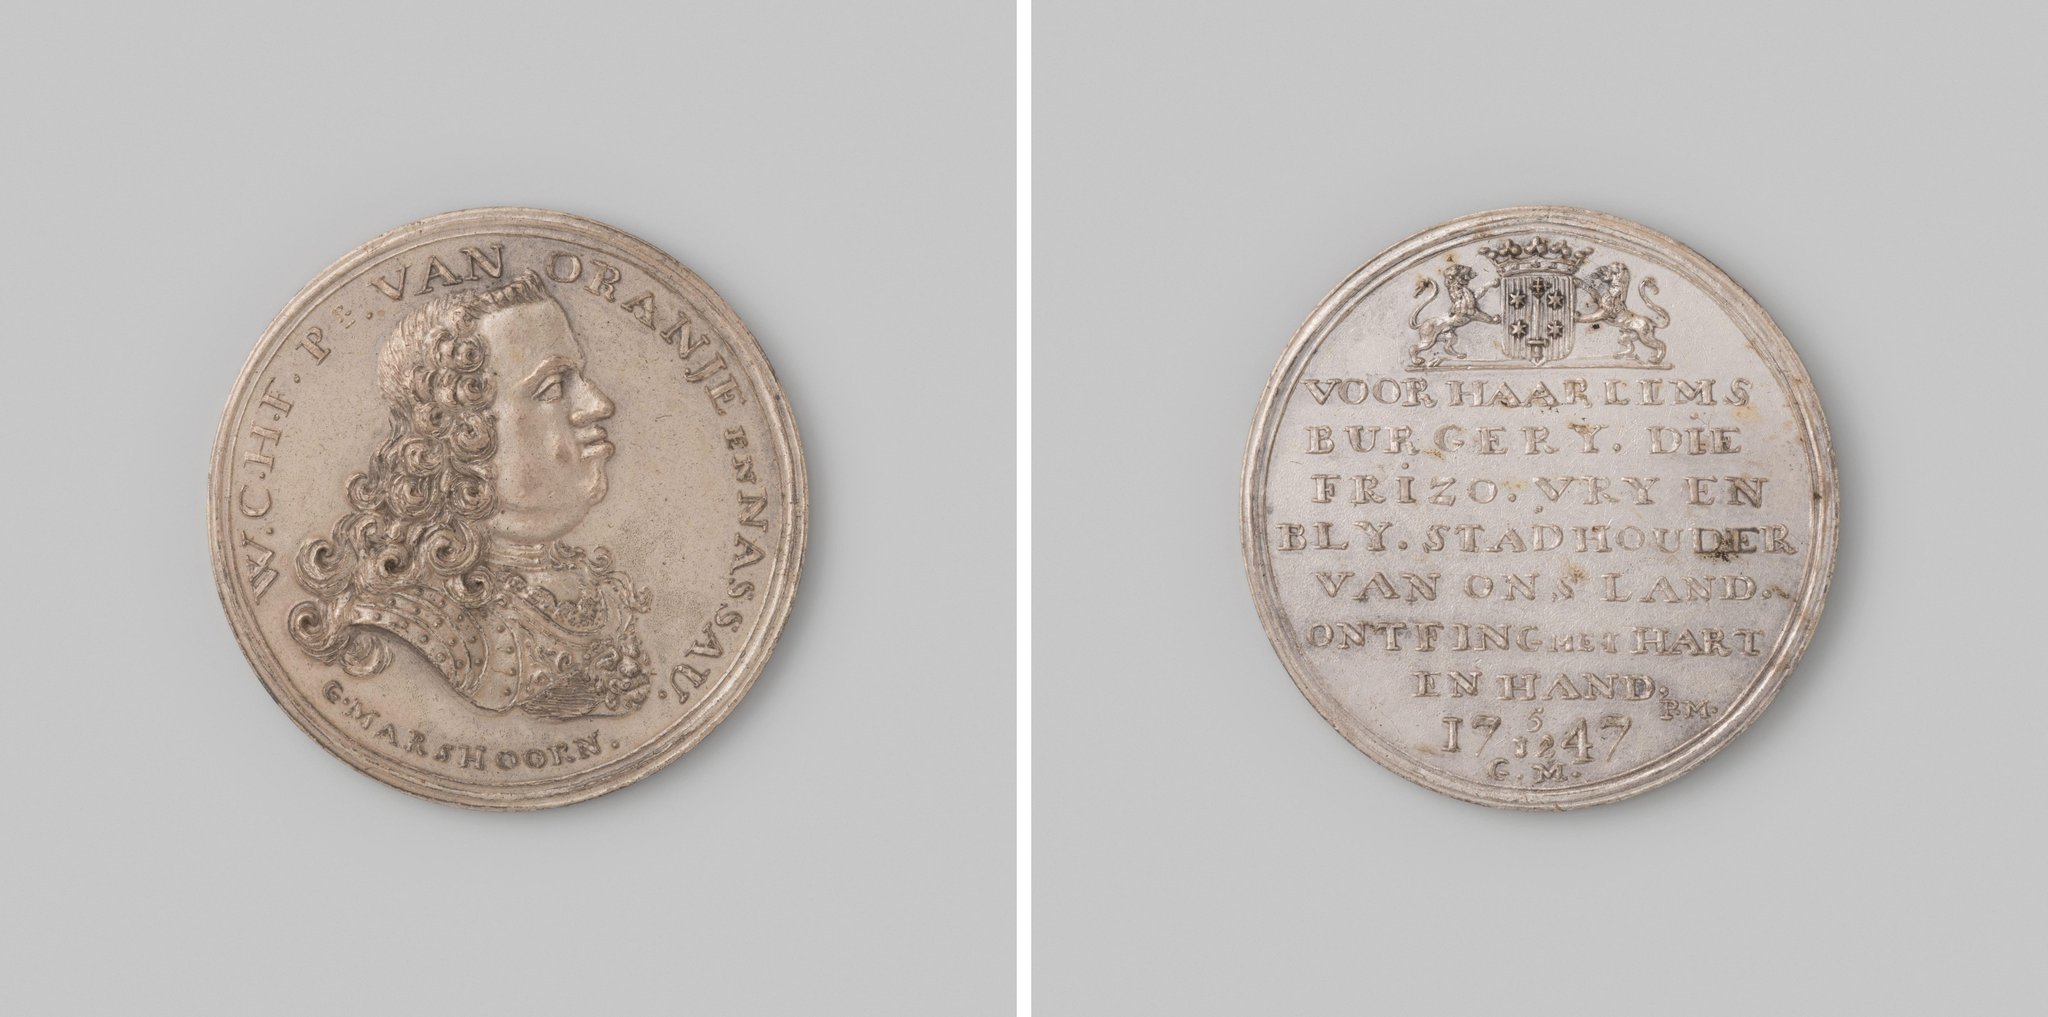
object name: history medal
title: Gedenkpenning aan de schutterij van Haarlem, vereerd voor de diensten bewezen gedurende den doortocht van Prins W.C.H. Friso aldaar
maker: gerrit marshoorn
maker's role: medailleur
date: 1747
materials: silver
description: Zilveren penning. Voorzijde: naar links gewend borstbeeld van de Prins, in harnas en met een ordelint versierd. Omschrift: W C H F(riso) PR(ins) VAN ORANJE EN NASSAU. Onderaan: G(errit) MARSHOORN. Keerzijde: gekroond wapen van Haarlem met daaronder het opschrift: VOOR HAARLEMS/ BURGERY DIE/ FRIZO VRY EN/ BLY STADHOUDER/ VAN ONS LAND/ ONTFING MET HART/ EN HAND/ P.M./ 17 5-12 47.